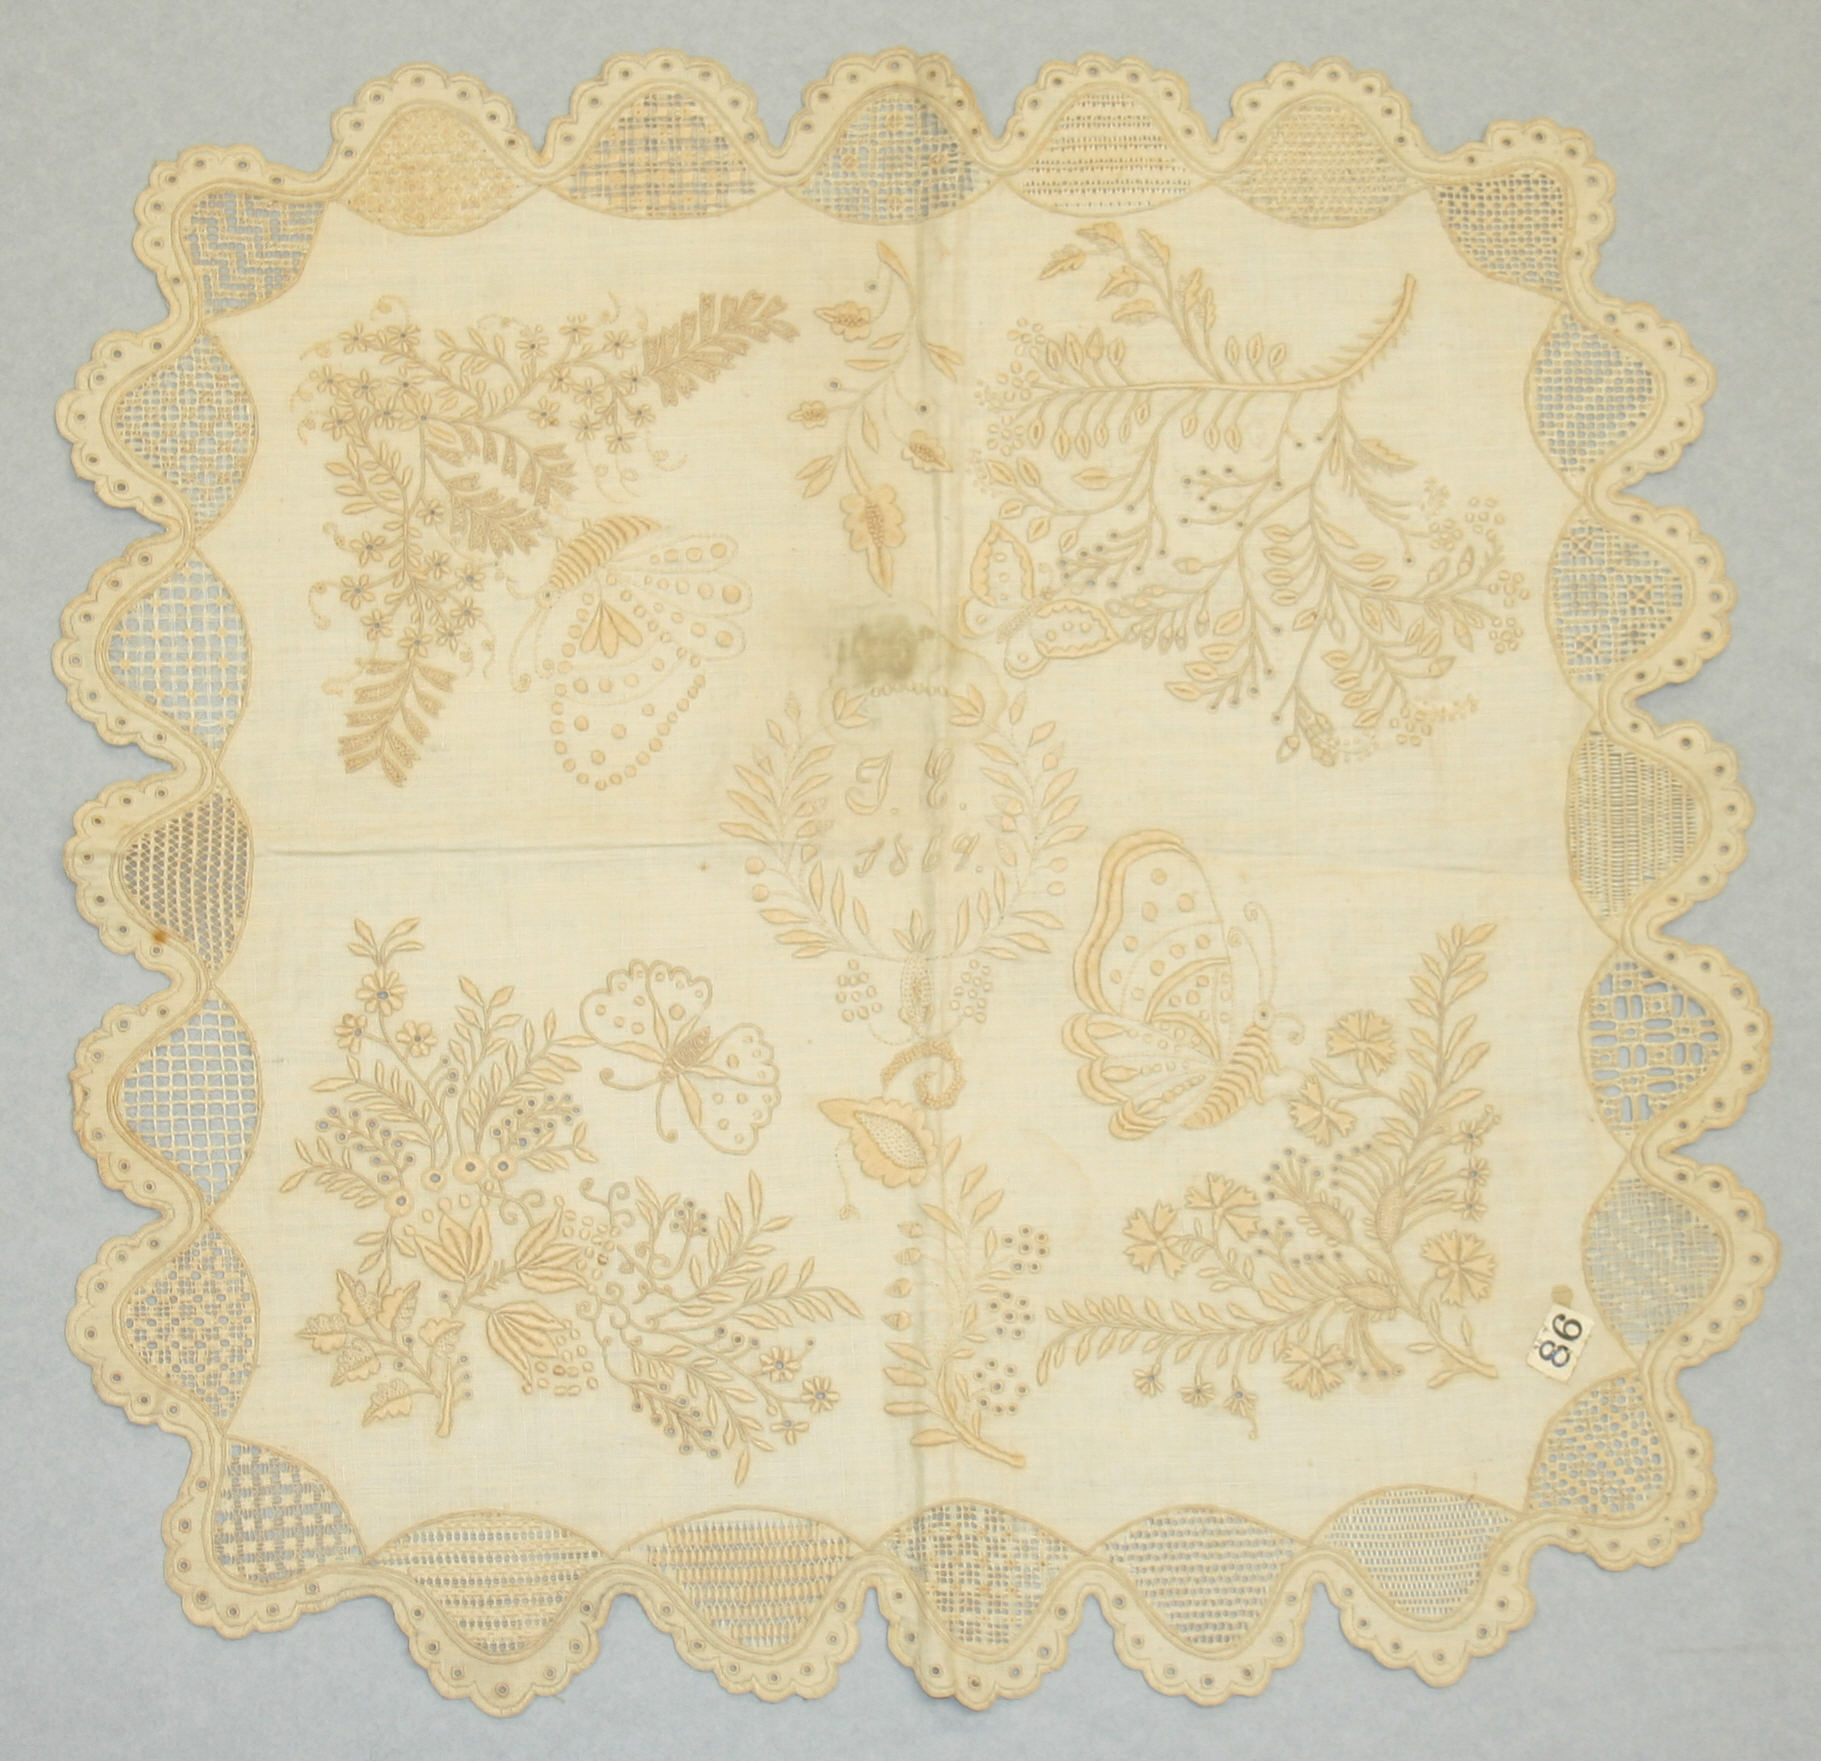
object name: sampler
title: Sampler (Dechado)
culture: mexican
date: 1869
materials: cotton, linen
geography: mexico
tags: butterflies,flowers,leaves,insignia